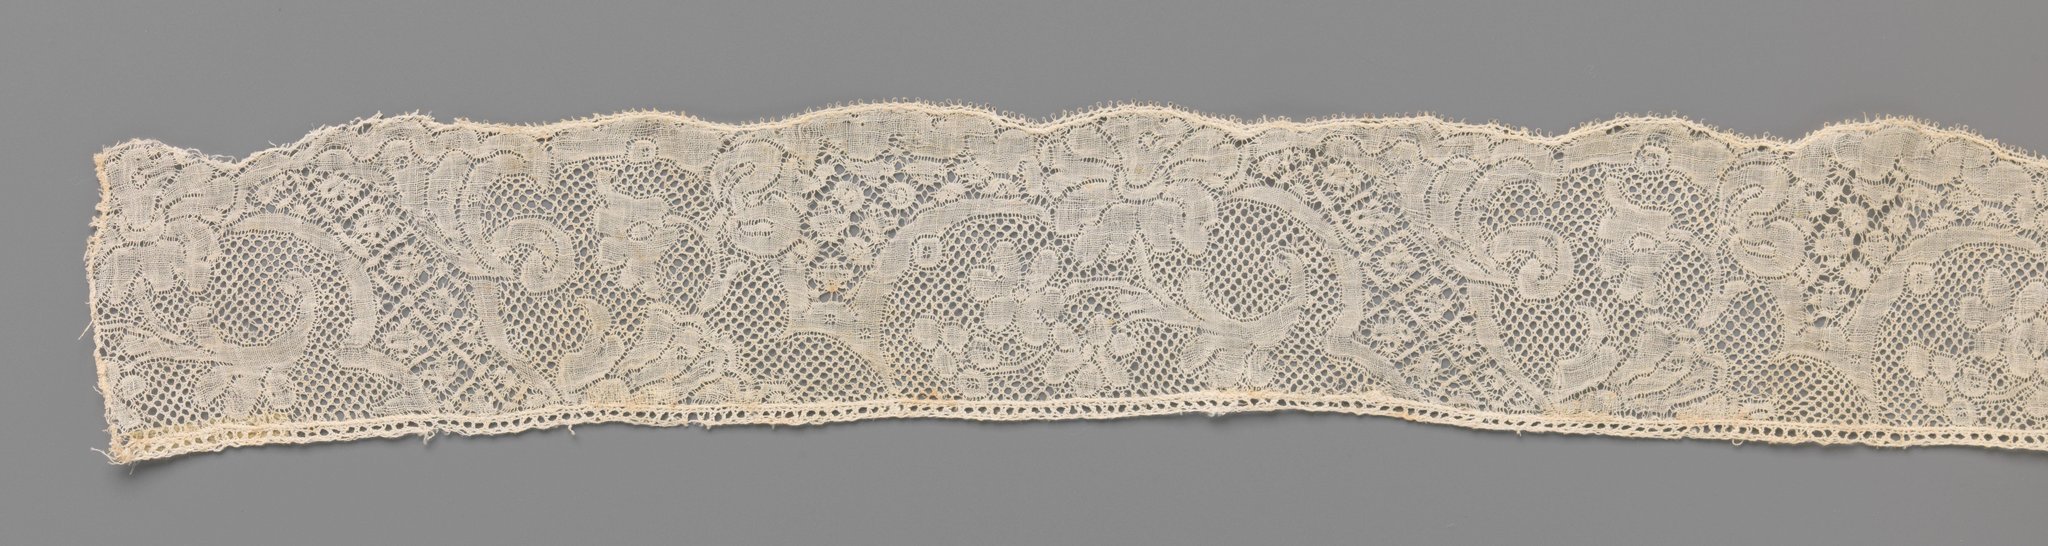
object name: strip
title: Strook kloskant met sierbanden en hangende anjer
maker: Anonymous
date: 1725-1749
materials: linen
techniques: lace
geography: southern netherlands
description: Strook naturelkleurige kloskant, Binche-kant. Het zich herhalende patroon bestaat uit sierbanden waarmee twee verschillende gelobde velden ontstaan. In het ene veld hangt een losse gebogen tak, met een grote hangende anjer, twee omhoog gerichte rozetbloempjes en een trosje met vijf bessen. In het andere veld hangt vanuit een gehalveerde waaiervormig bloem langs de bovenzijde een kelkbloempje naar beneden aan een gebogen stengel. De motieven zijn met elkaar verbonden door een traliegrond, een vijfgaatjesgrond. De motieven zijn gemaakt in linnenslag met uitsparingen en opengewerkte randjes. In de sierbanden zijn twee verschillende siergronden toegepast, met rozetmotiefjes en cirkelvormige motiefjes erin, al dan niet in een ruitjespatroon. De bovenzijde van de strook is afgewerkt met een apart geklost bandje, met grovere draden. De zeer flauw geschulpte onderzijde is rommelig en lijkt geen onderdeel te zijn van het oorspronkelijke patroon, de draad met picots eraan wijkt sterk af van de draden uit het kloswerk.